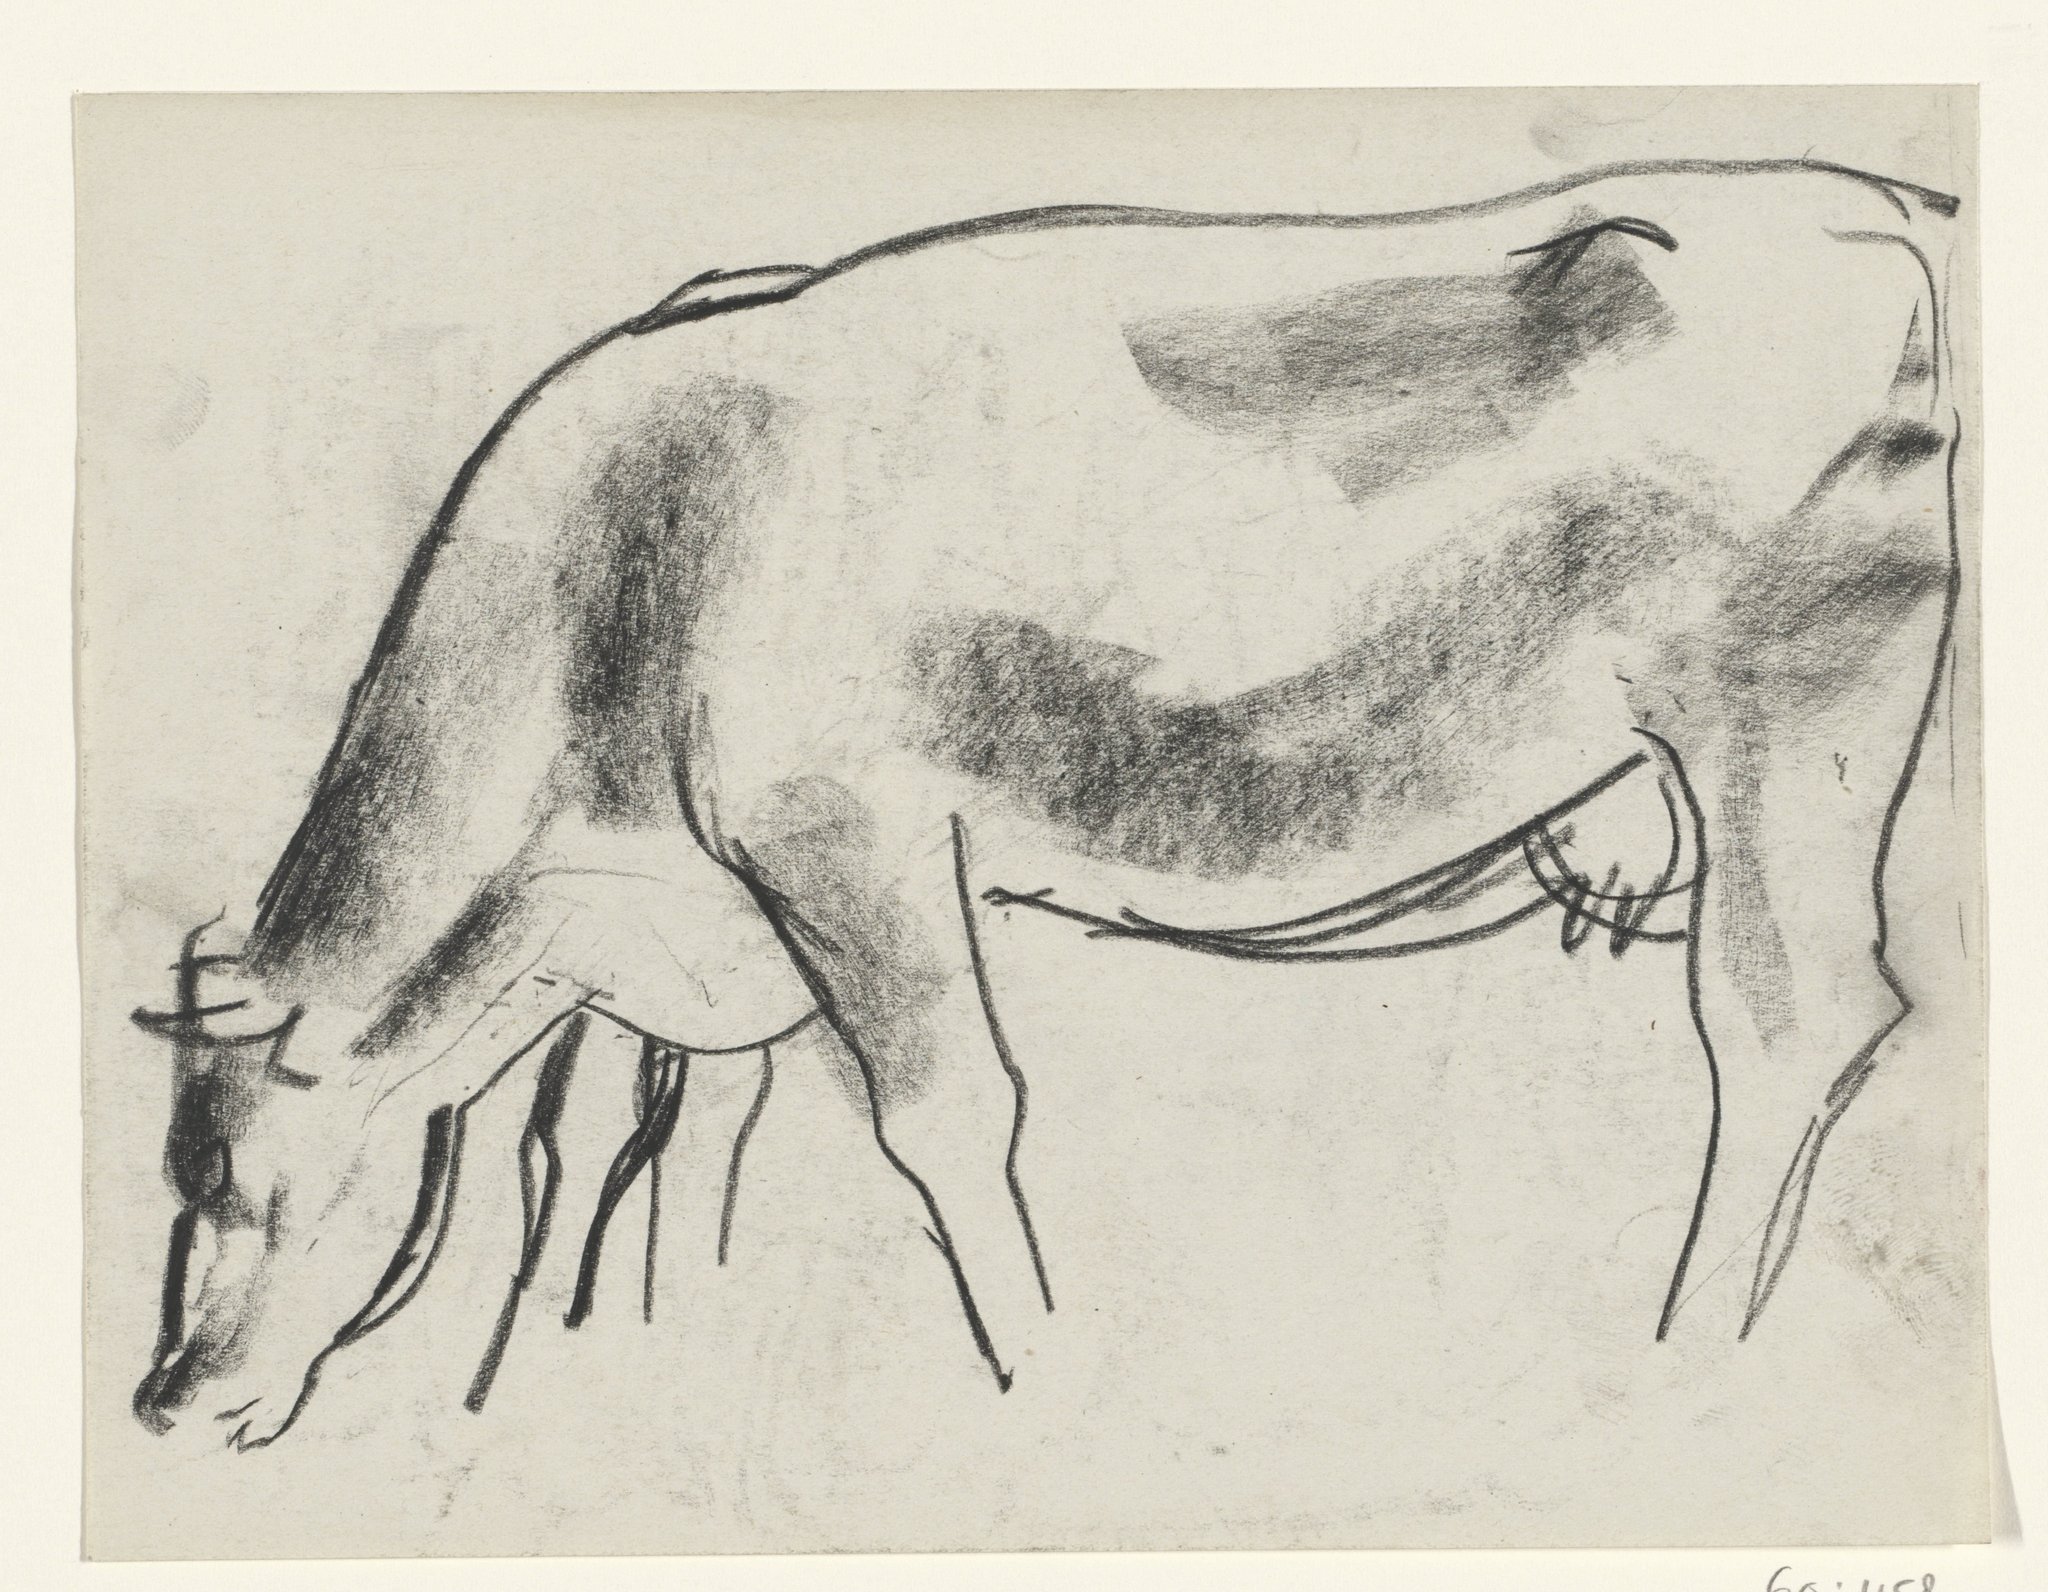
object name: drawing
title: Grazende koe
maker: leo gestel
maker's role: draughtsman, print maker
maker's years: 1881-1941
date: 1891-1941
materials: chalk, paper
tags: cow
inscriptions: collector's mark: Lugt 2228